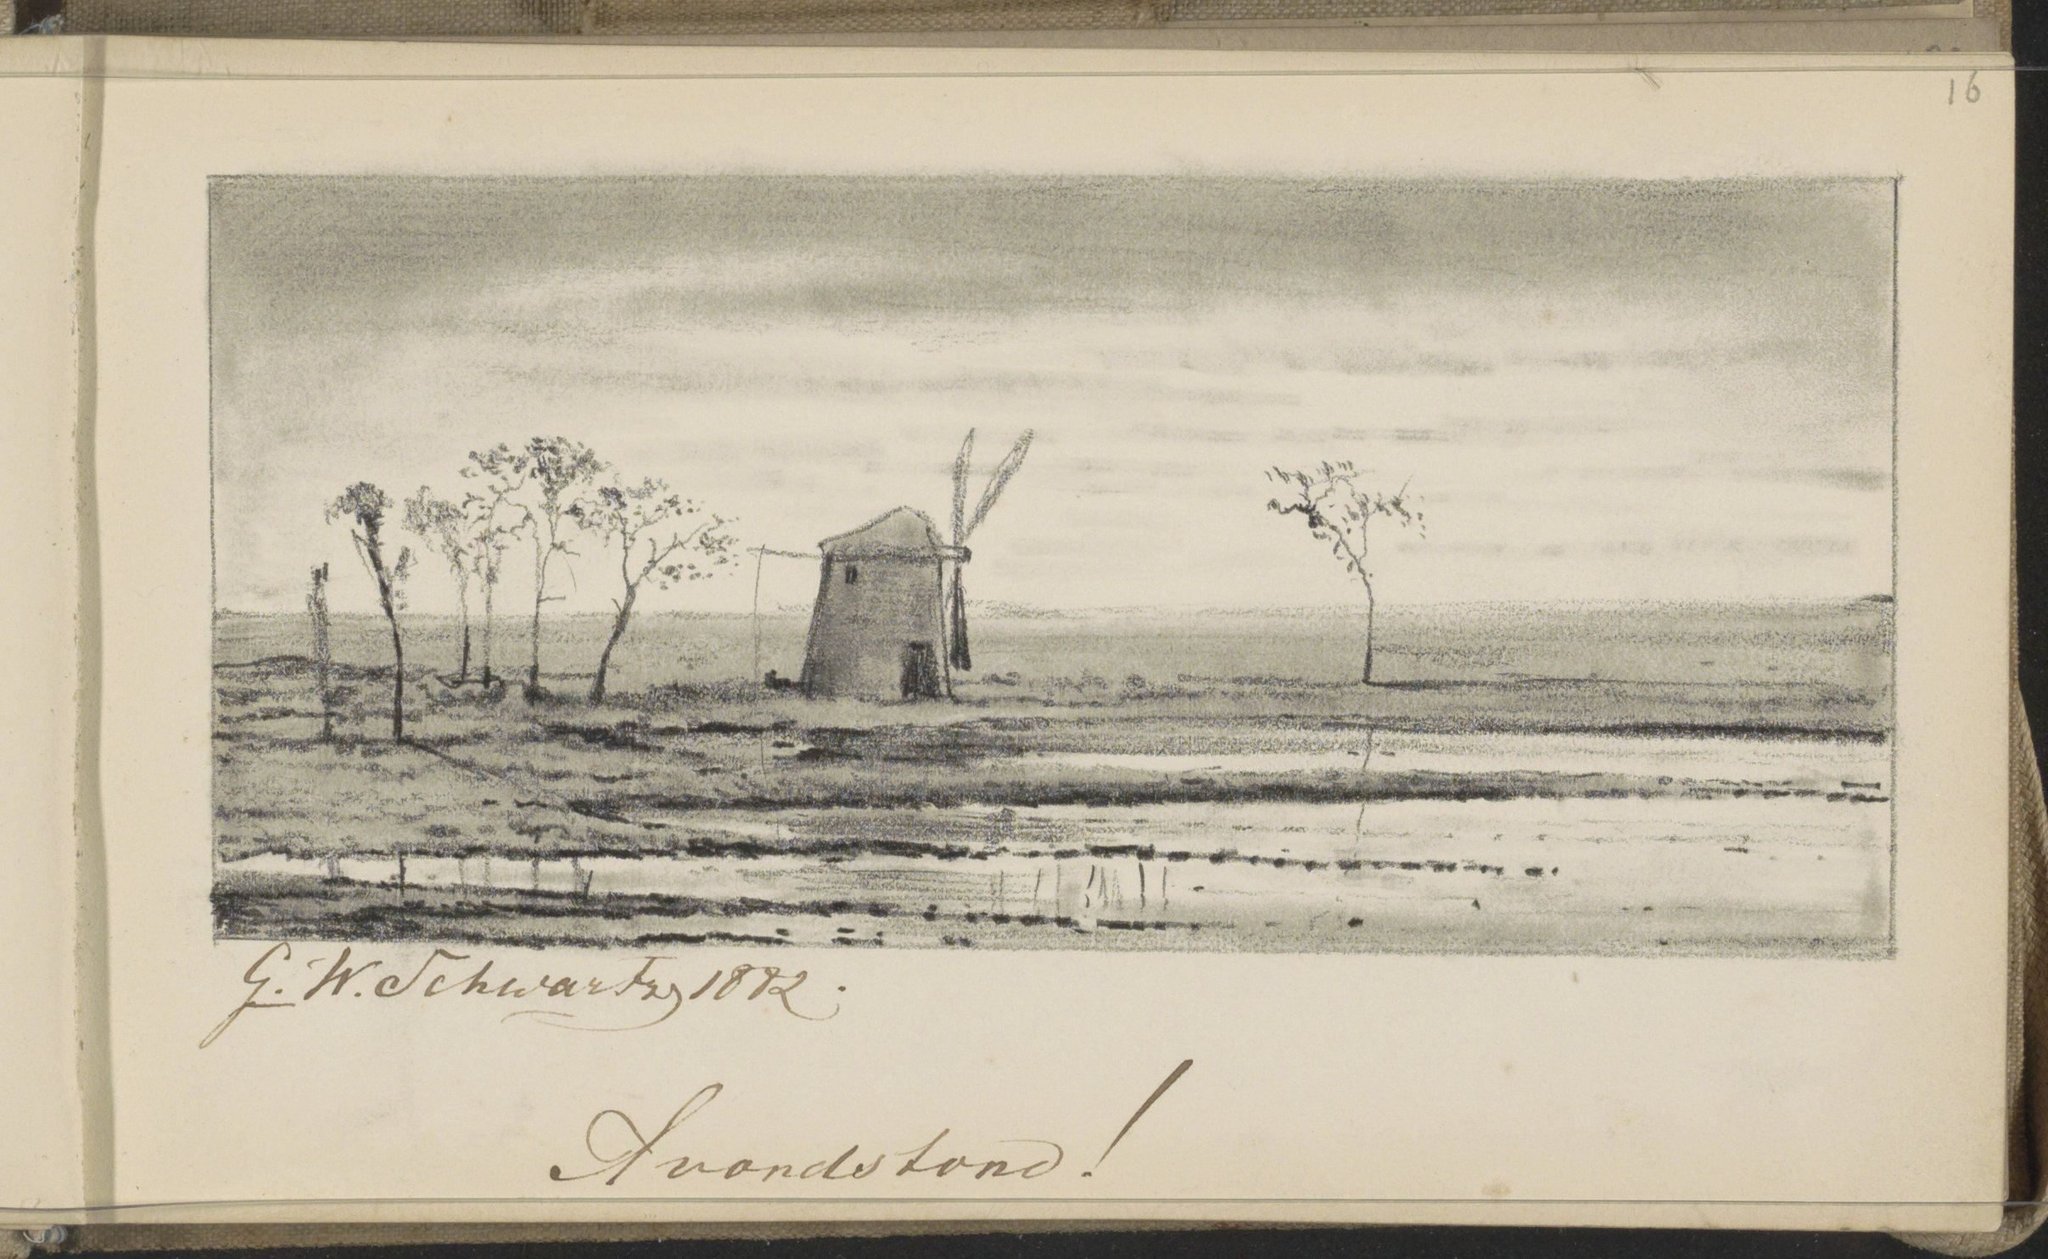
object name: sketchbook leaf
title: Landschap met water en een molen bij avond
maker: george washington schwartze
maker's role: draughtsman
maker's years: 1857-1909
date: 1882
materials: paper, pencil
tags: dusk, evening twilight, landscapes with waters, waterscapes, seascapes (in the temperate zone), windmill in landscape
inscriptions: signature and date: ‘G.W.Schwartze. 1882.’, title: ‘Avondstond!’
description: Tekening in een kader. Blad 16 recto uit een schetsboek met 54 bladen.